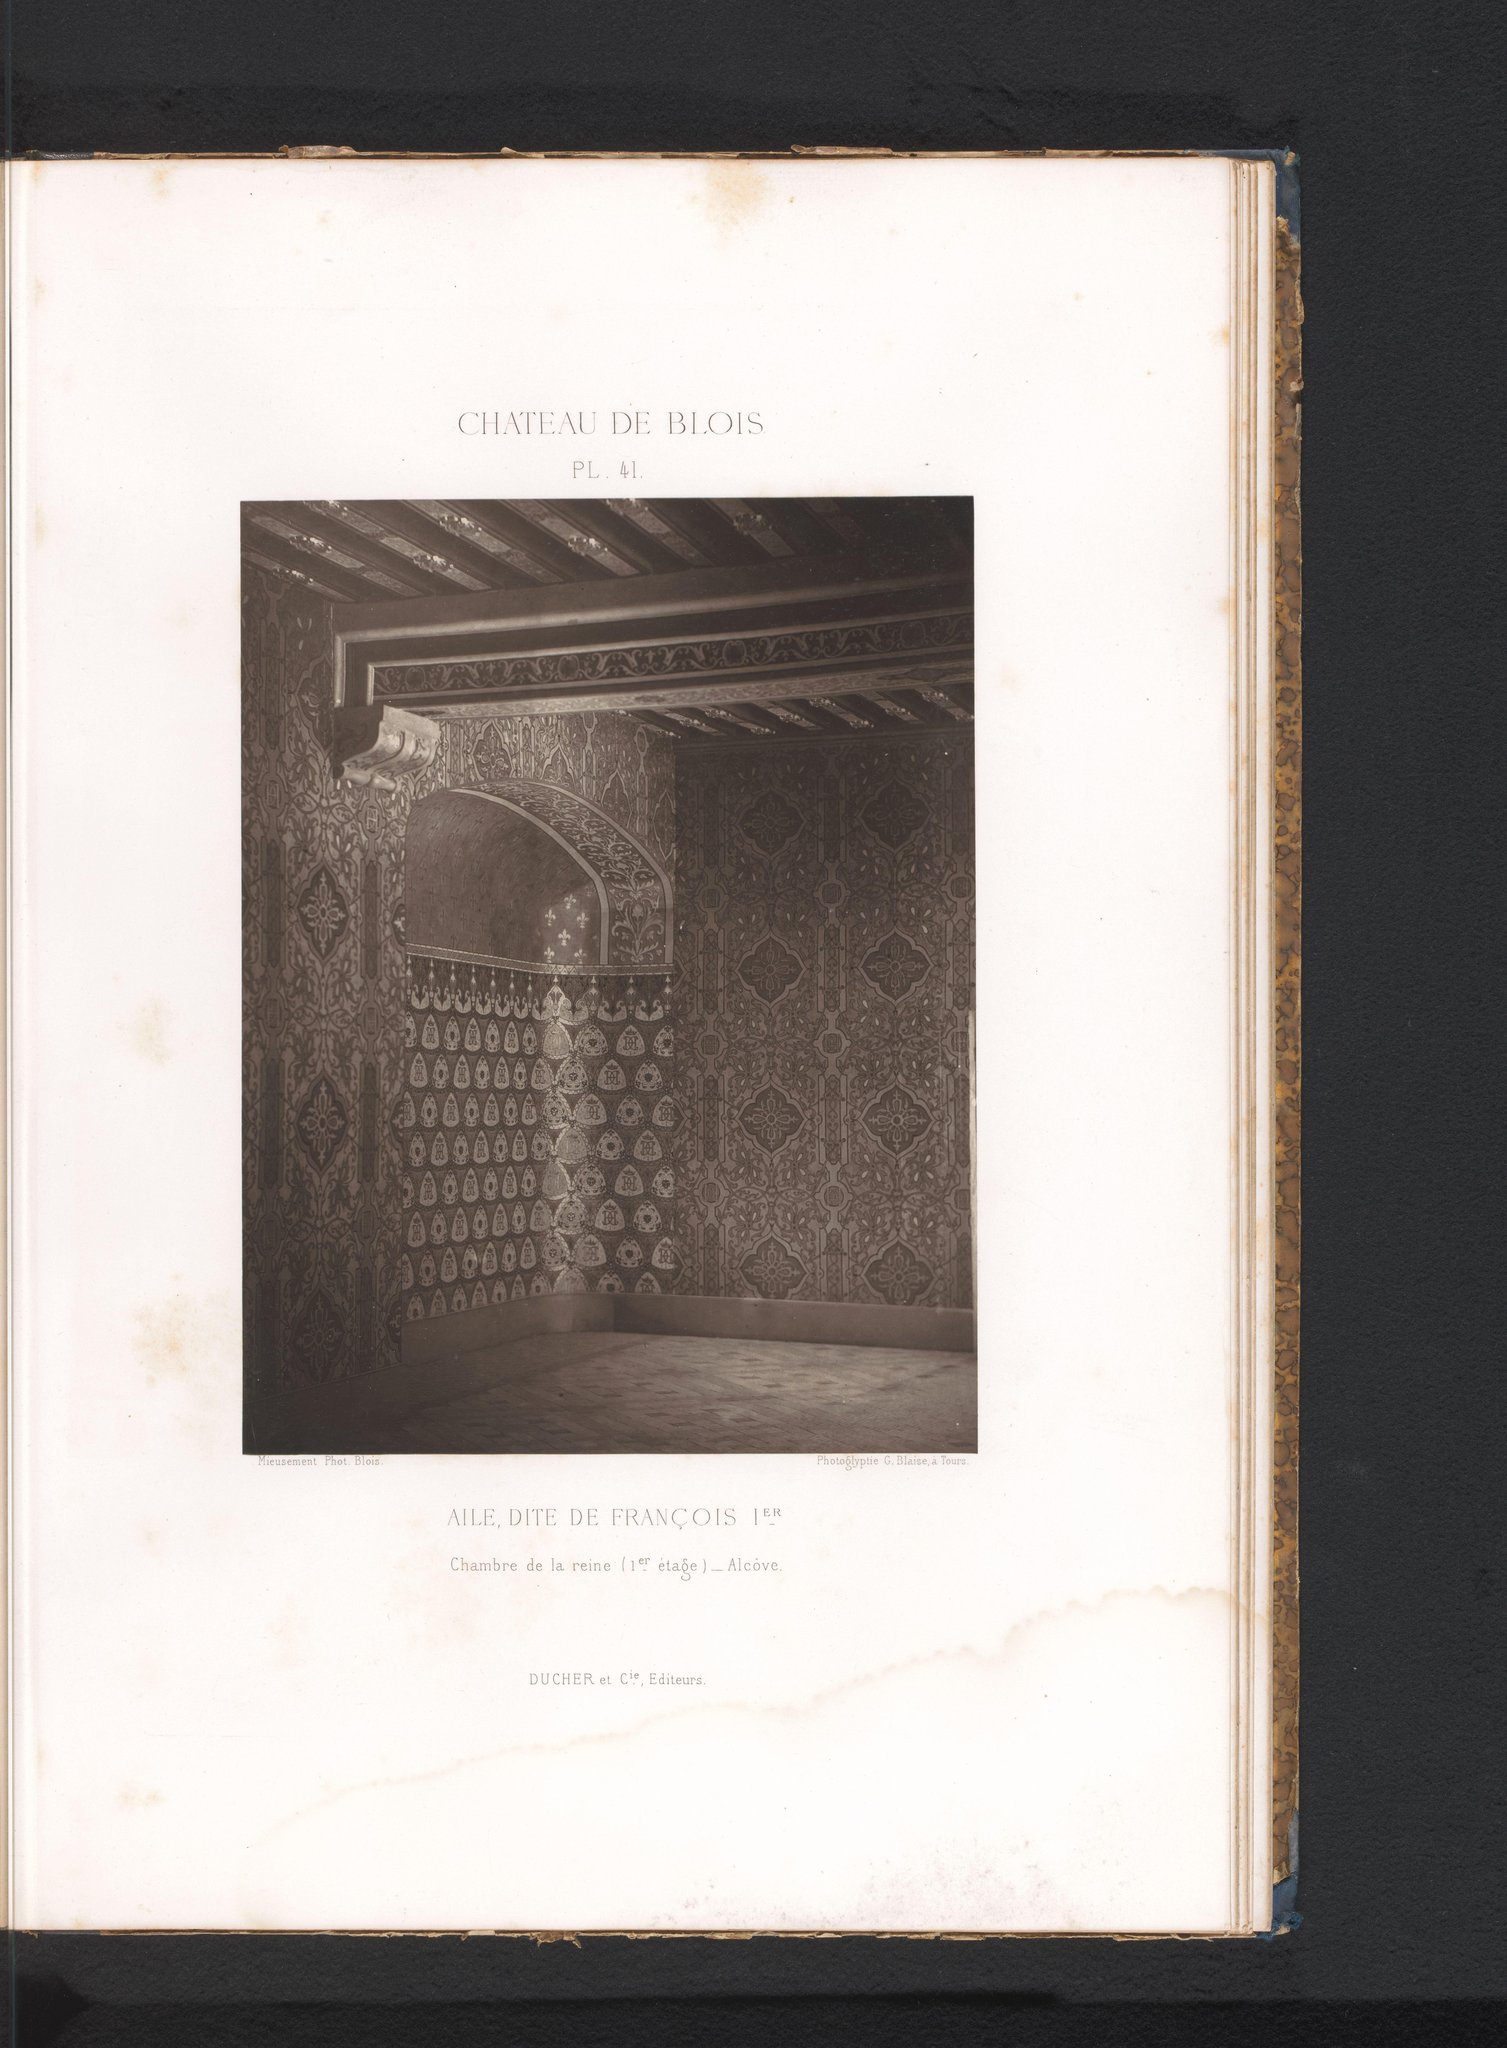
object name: page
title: Aile, dite de François Ier. Chambre de la reine (1er étage) - Alcôve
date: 1870-1875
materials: paper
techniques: woodburytype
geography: blois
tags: castle, other rooms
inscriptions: number: ‘PL. 41.’